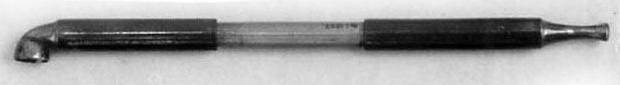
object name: tobacco pipe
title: Tobacco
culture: japanese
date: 1801-1900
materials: metal